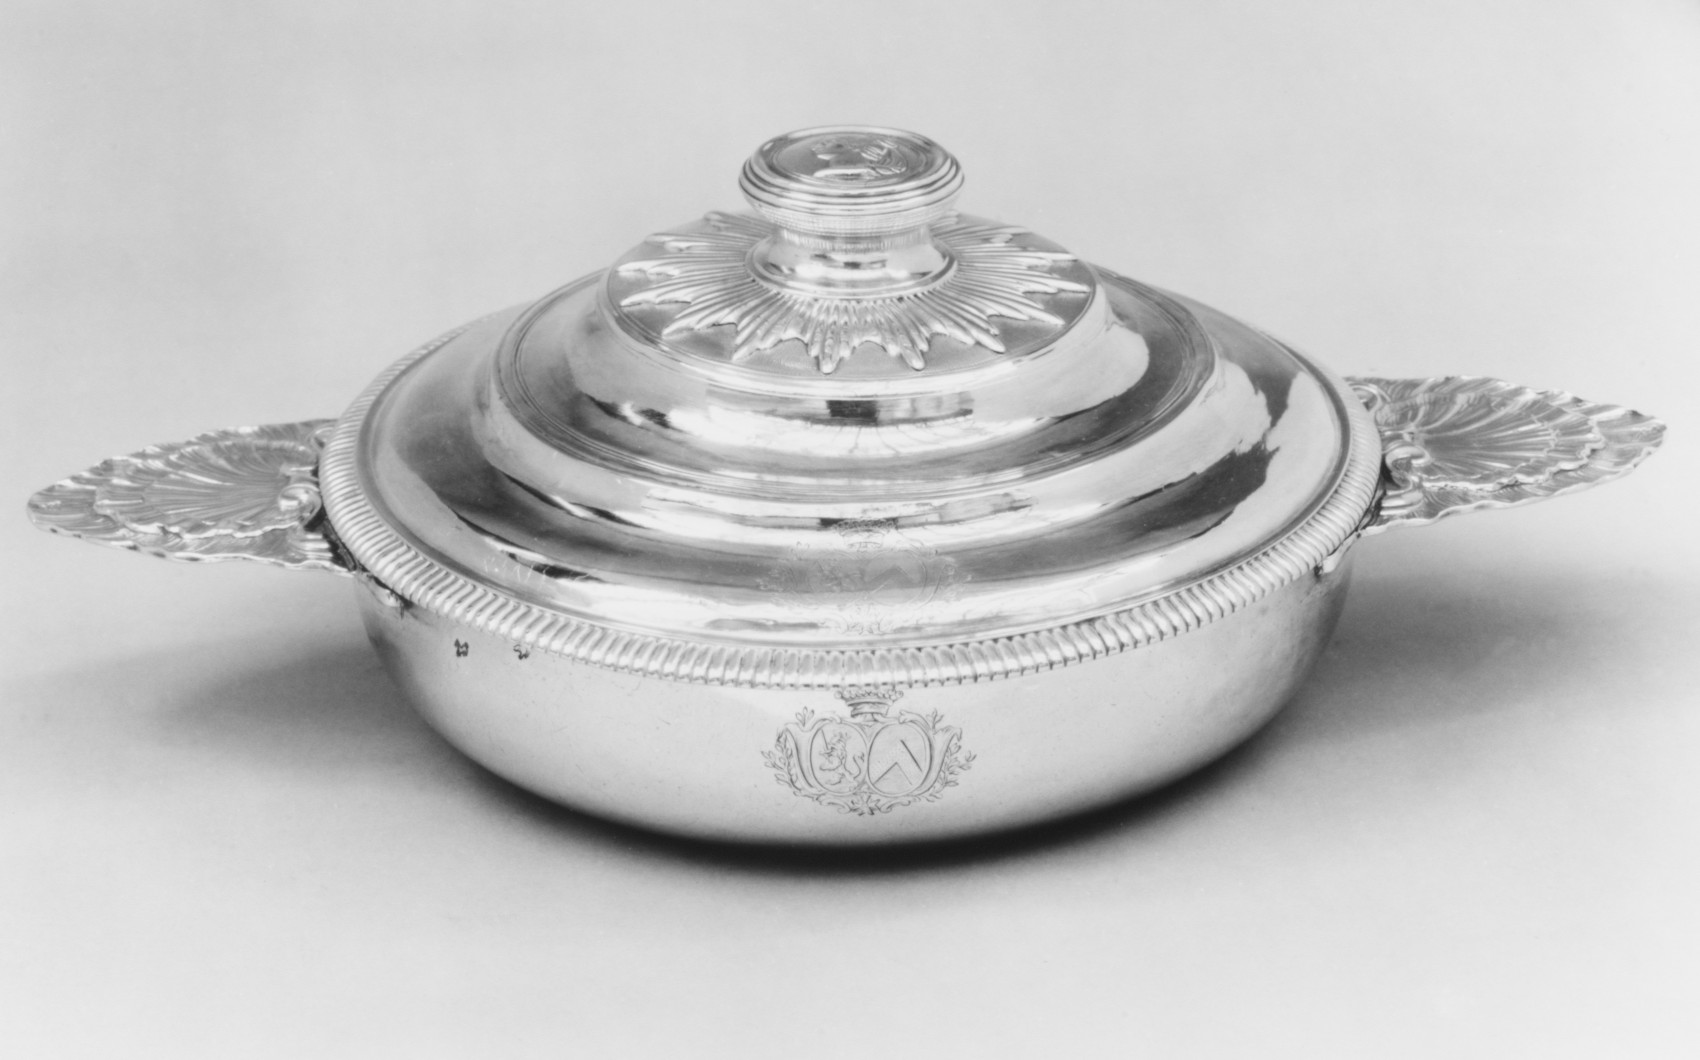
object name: bowl with cover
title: Bowl with cover (Écuelle)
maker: antoine plot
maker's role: maker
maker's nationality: french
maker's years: 1701-1772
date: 1735-1736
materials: silver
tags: coat of arms